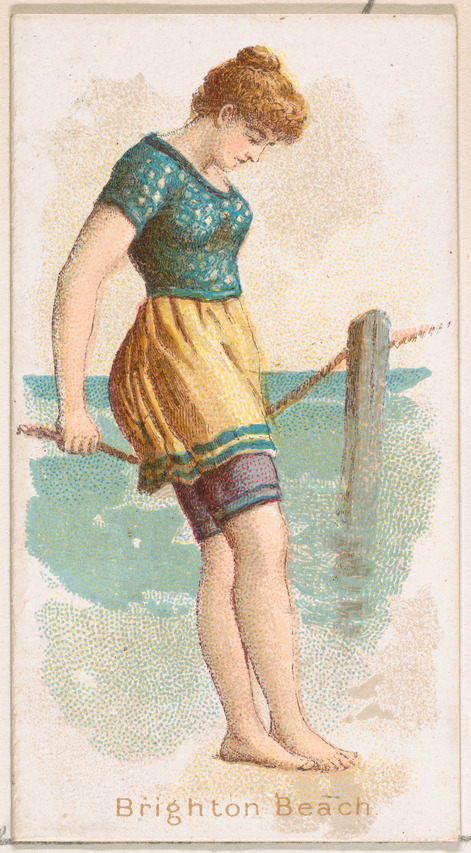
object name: print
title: Brighton Beach, from the Fancy Bathers series (N187) issued by Wm. S. Kimball & Co.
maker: william s. kimball & company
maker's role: publisher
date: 1889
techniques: color lithograph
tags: profiles,women,beaches